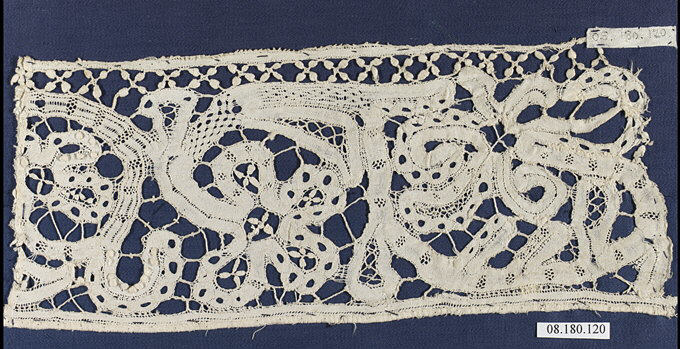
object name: piece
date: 1701-1800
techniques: lace